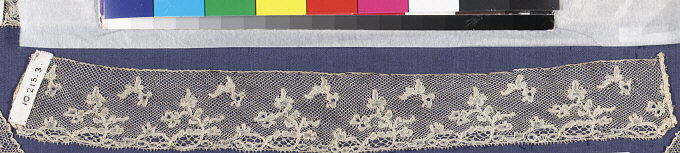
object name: piece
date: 1801-1900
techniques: lace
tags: leaves